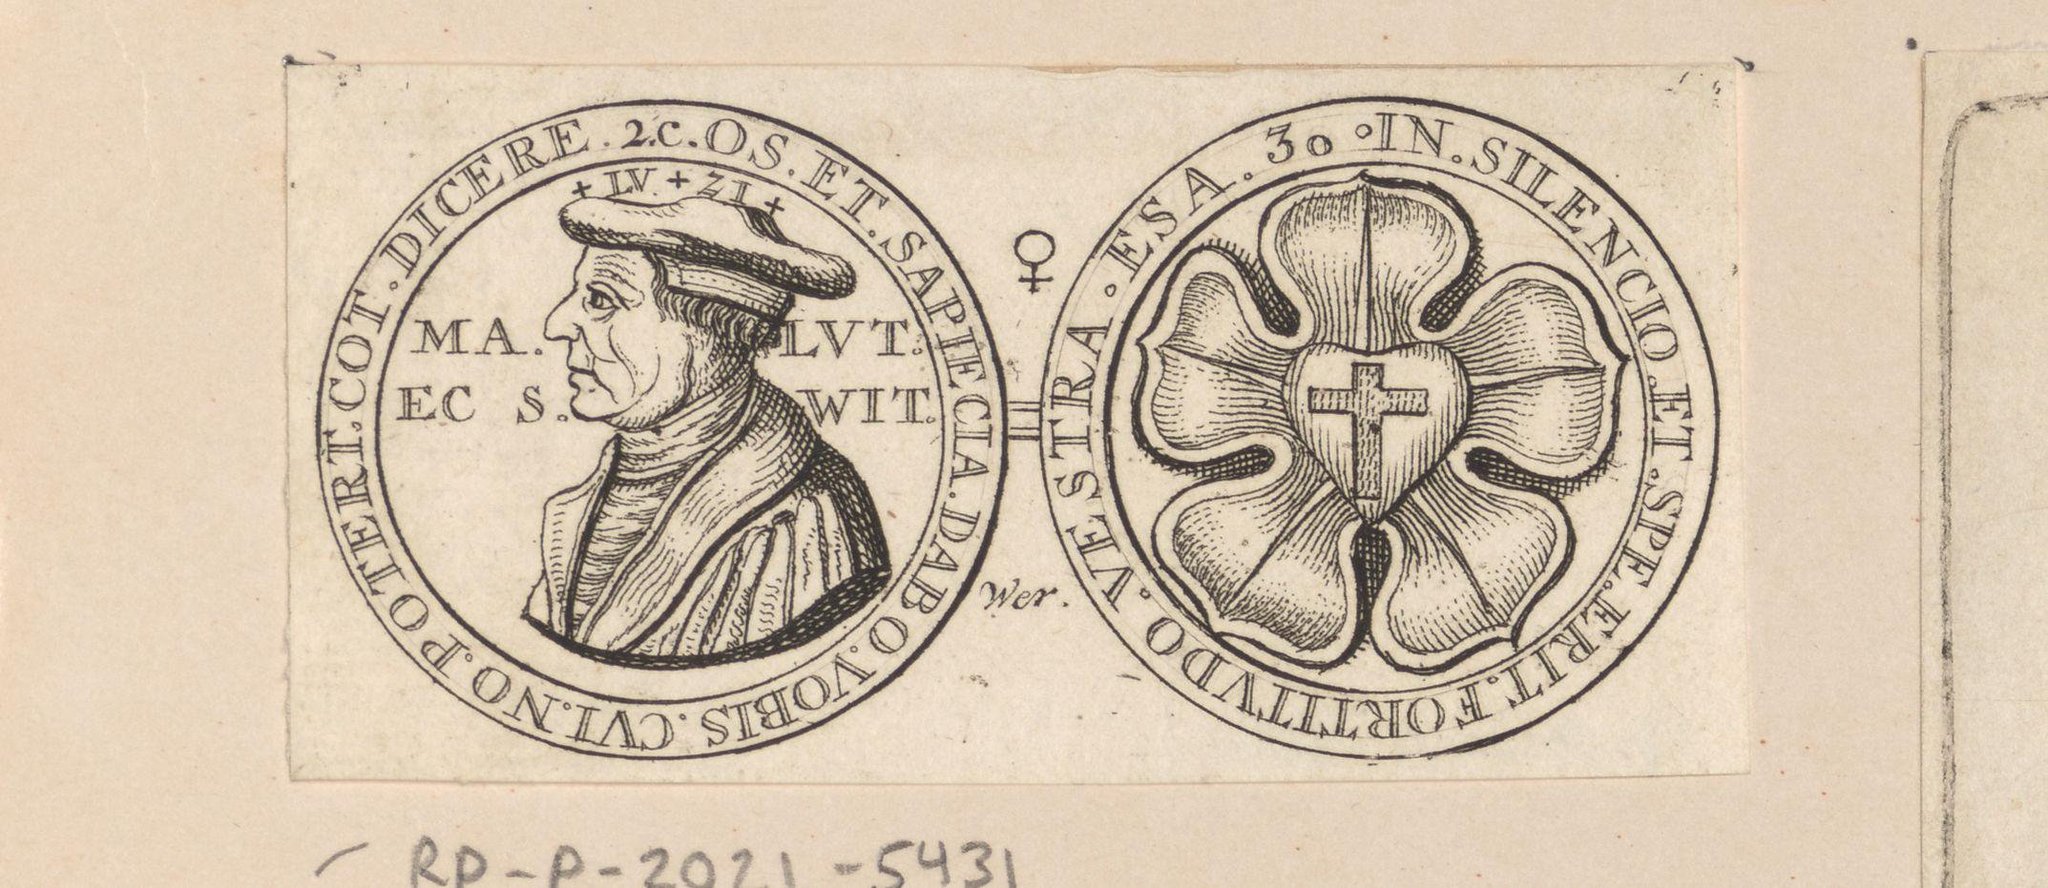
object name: print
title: Voor- en achterzijde van een penning met het portret van Martin Luther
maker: Anonymous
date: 1728-1734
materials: paper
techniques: etching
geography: northern netherlands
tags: priest, martin luther, historical persons, medal (considered as a piece of sculpture, regardless of its specific function)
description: Prent met tekst in boekdruk op verso gebruikt in: Seckendorf, Veit-Ludwig von. Uitvoerige en onpartydige historie der reformatie door dr. Martin Luther (...). Delft: Reinier Boitet, 1728, dl. 3. En in de druk uit 1730, en mogelijk ook al in 1726. En in: Juncker, Christian. De goude en zilvere eergedagtenis van Dr. M. Luther (...). Den Haag: s.n., 1734. Op de prent het teken voor het materiaal koper. De letters Wer. verwijzen naar de eigenaar van de penning.